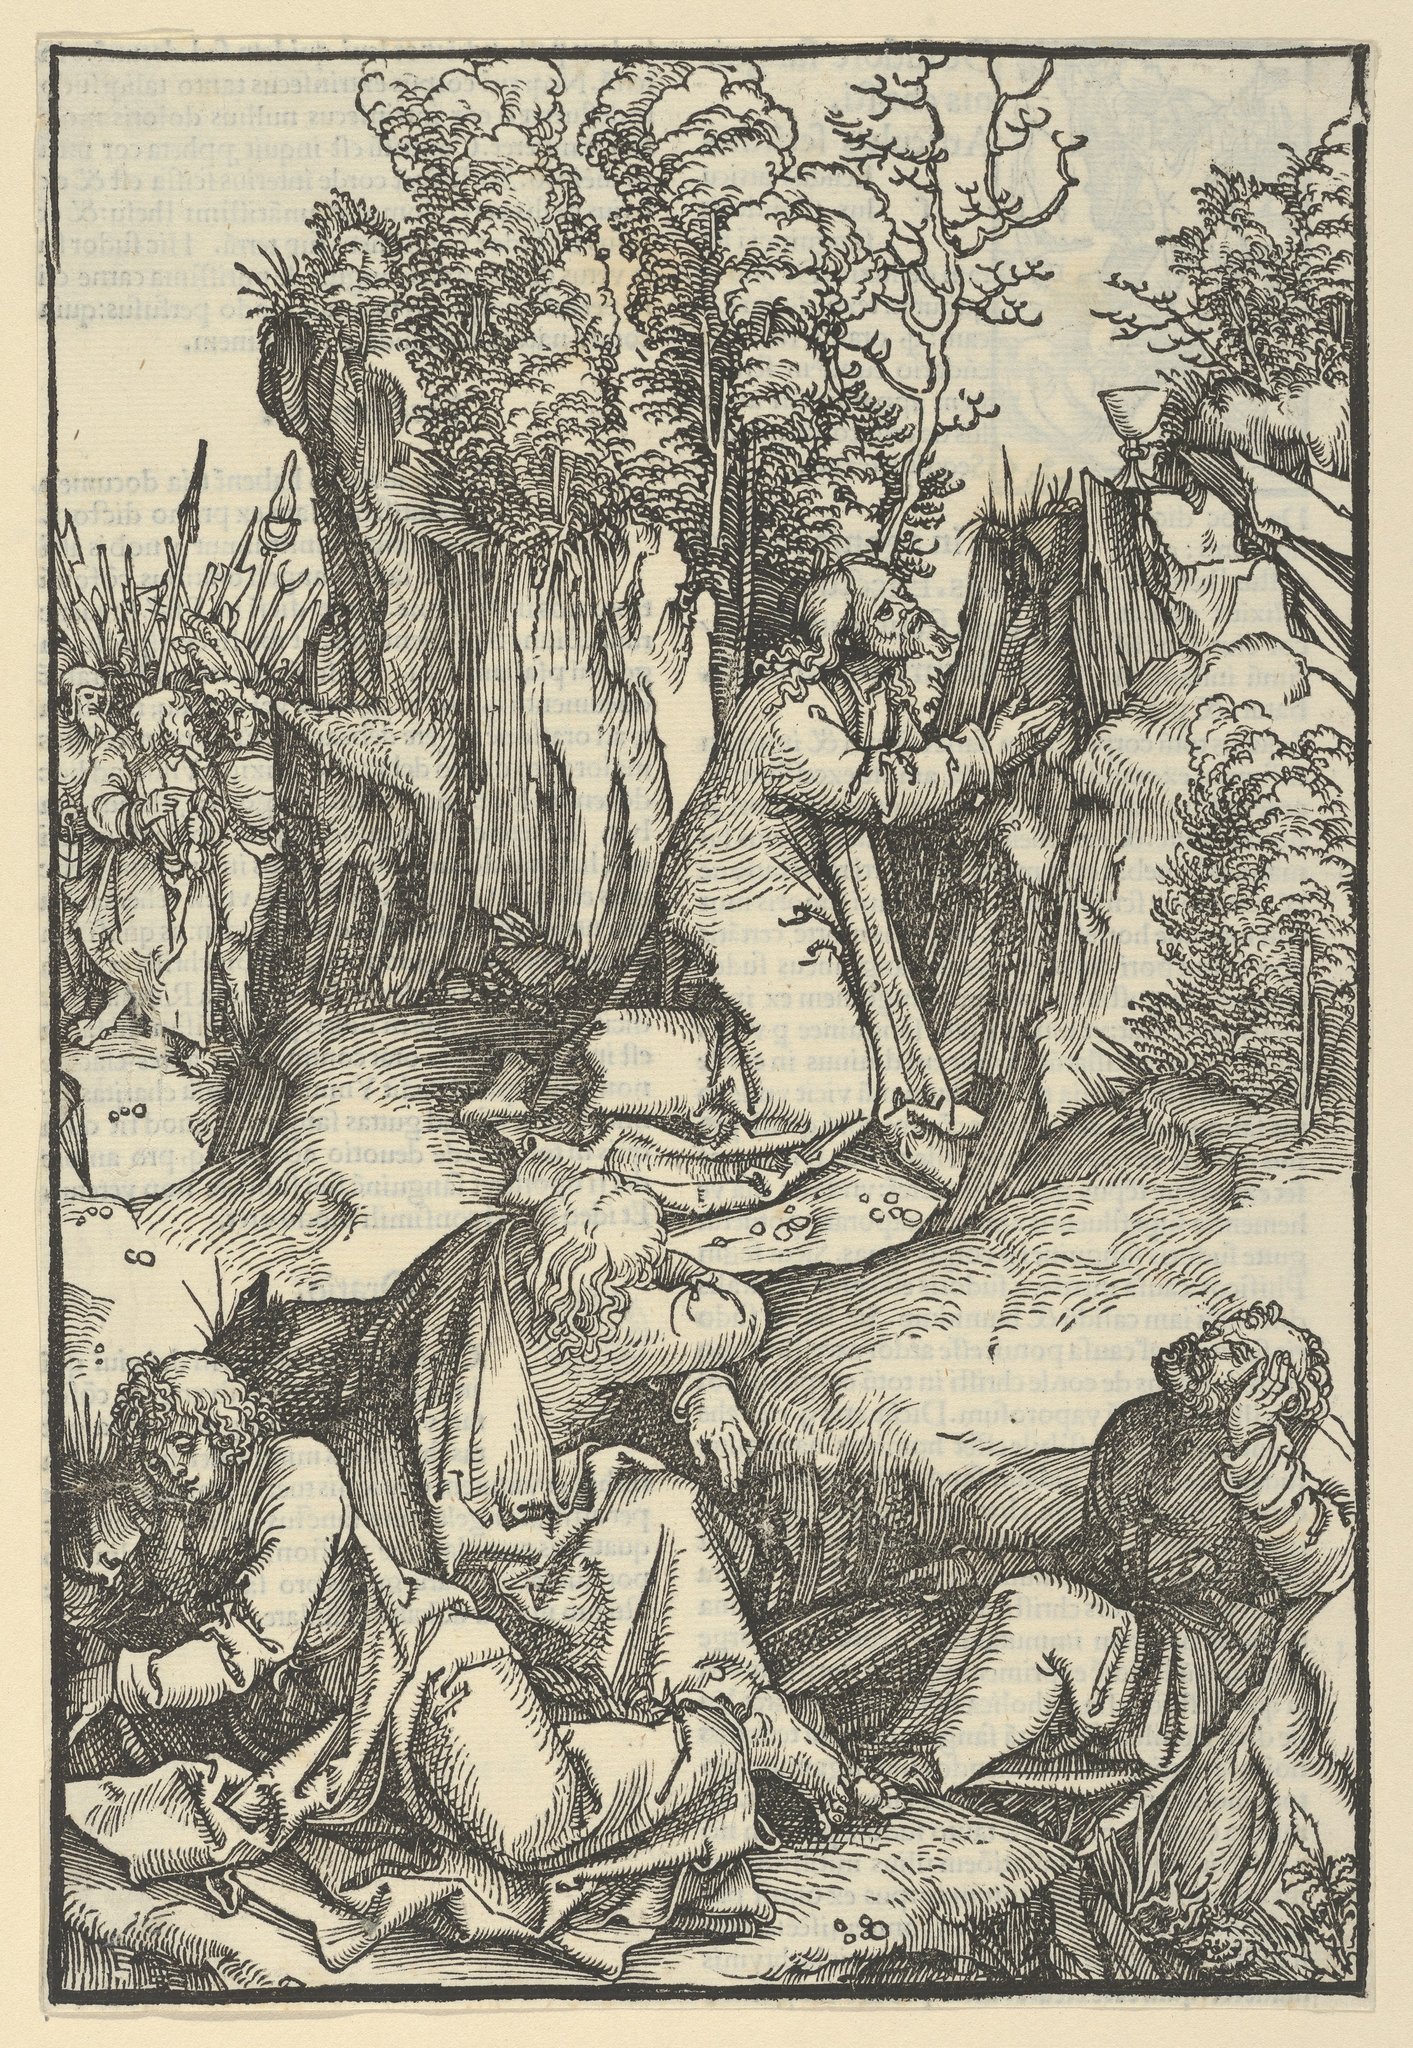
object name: print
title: The Agony in the Garden, from Speculum passionis domini nostri Ihesu Christi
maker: hans schäufelein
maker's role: artist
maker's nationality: german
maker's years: 1480-1540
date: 1507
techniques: woodcut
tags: suffering,men,christ